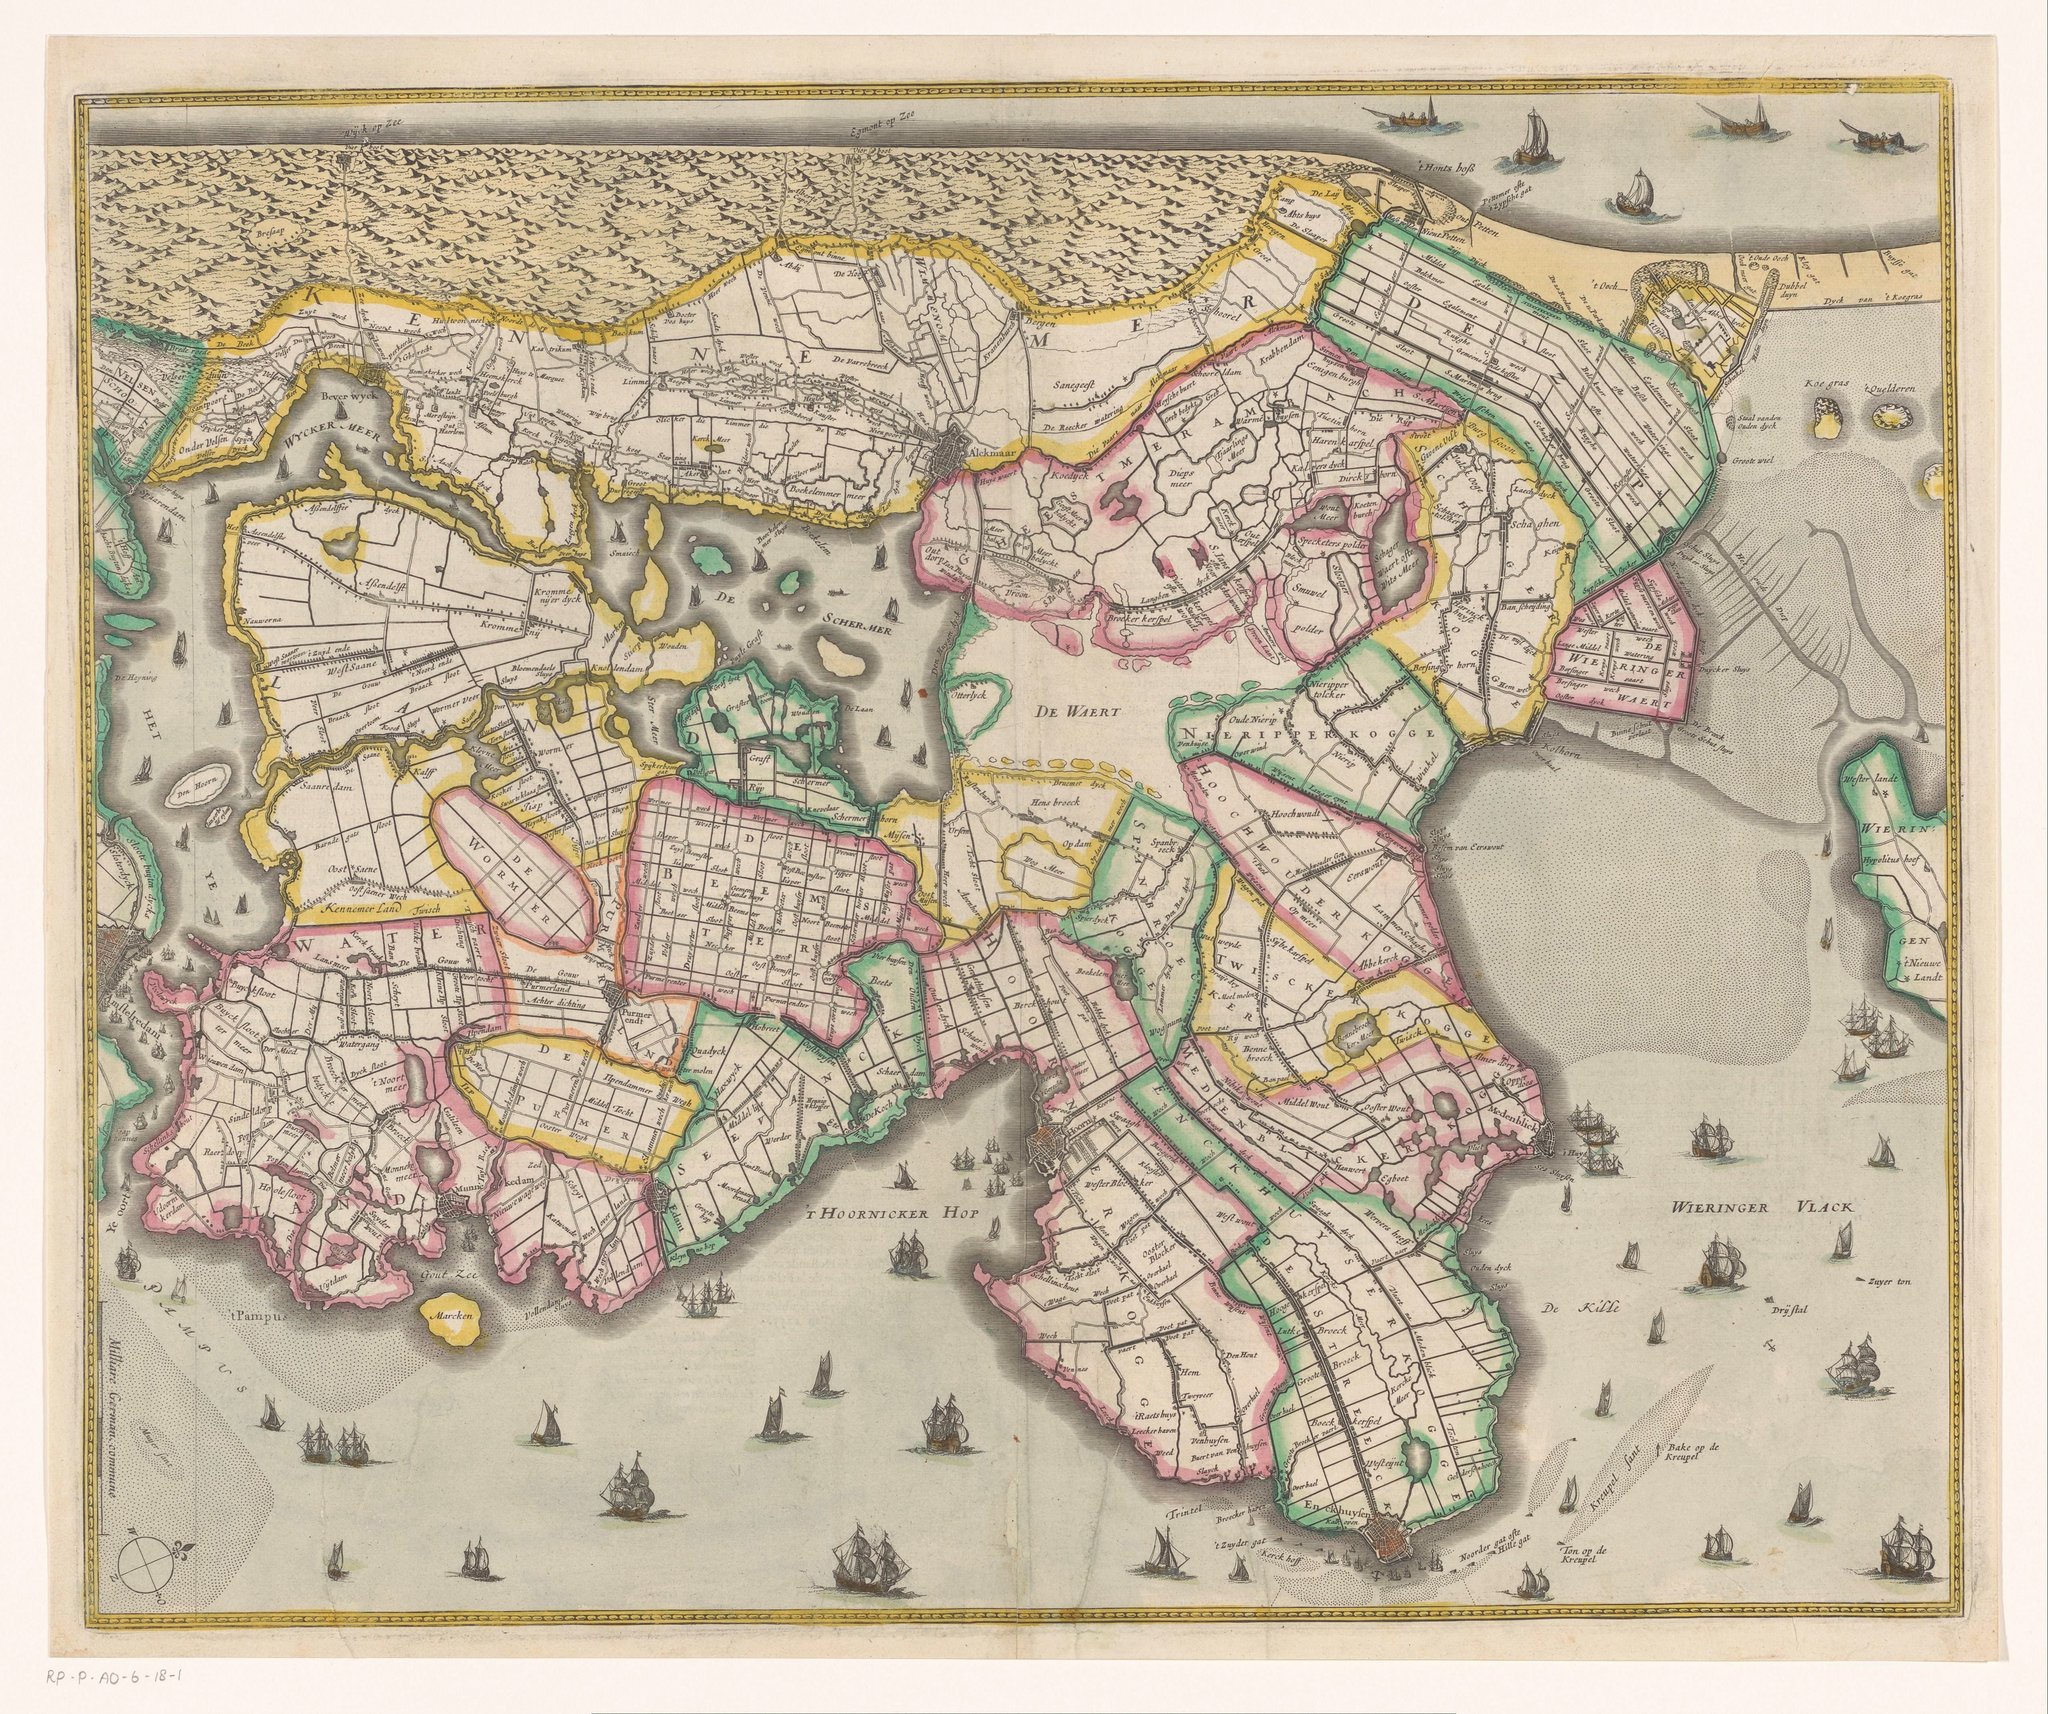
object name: map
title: Kaart van Noord-Holland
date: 1629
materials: paper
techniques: engraving, etching, hand coloring, letterpress printing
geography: amsterdam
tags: maps of separate countries or regions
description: Prent gebruikt in: Mercator, Gerard en Jodocus Hondius. Atlas ou representation du monde universel, et des parties d’icelui (…). 2 delen. Amsterdam: Henricus Hondius, 1633, dl. 1. Of in: Mercator, Gerard en Jodocus Hondius. L'appendice de l'atlas de Gerard Mercator et Iudocus Hondius: contenant diverses nouvelles tables et descriptions (…). Amsterdam: Henricus Hondius, 1633. RP-P-AO-6-18-2 is een kopie van deze kaart.